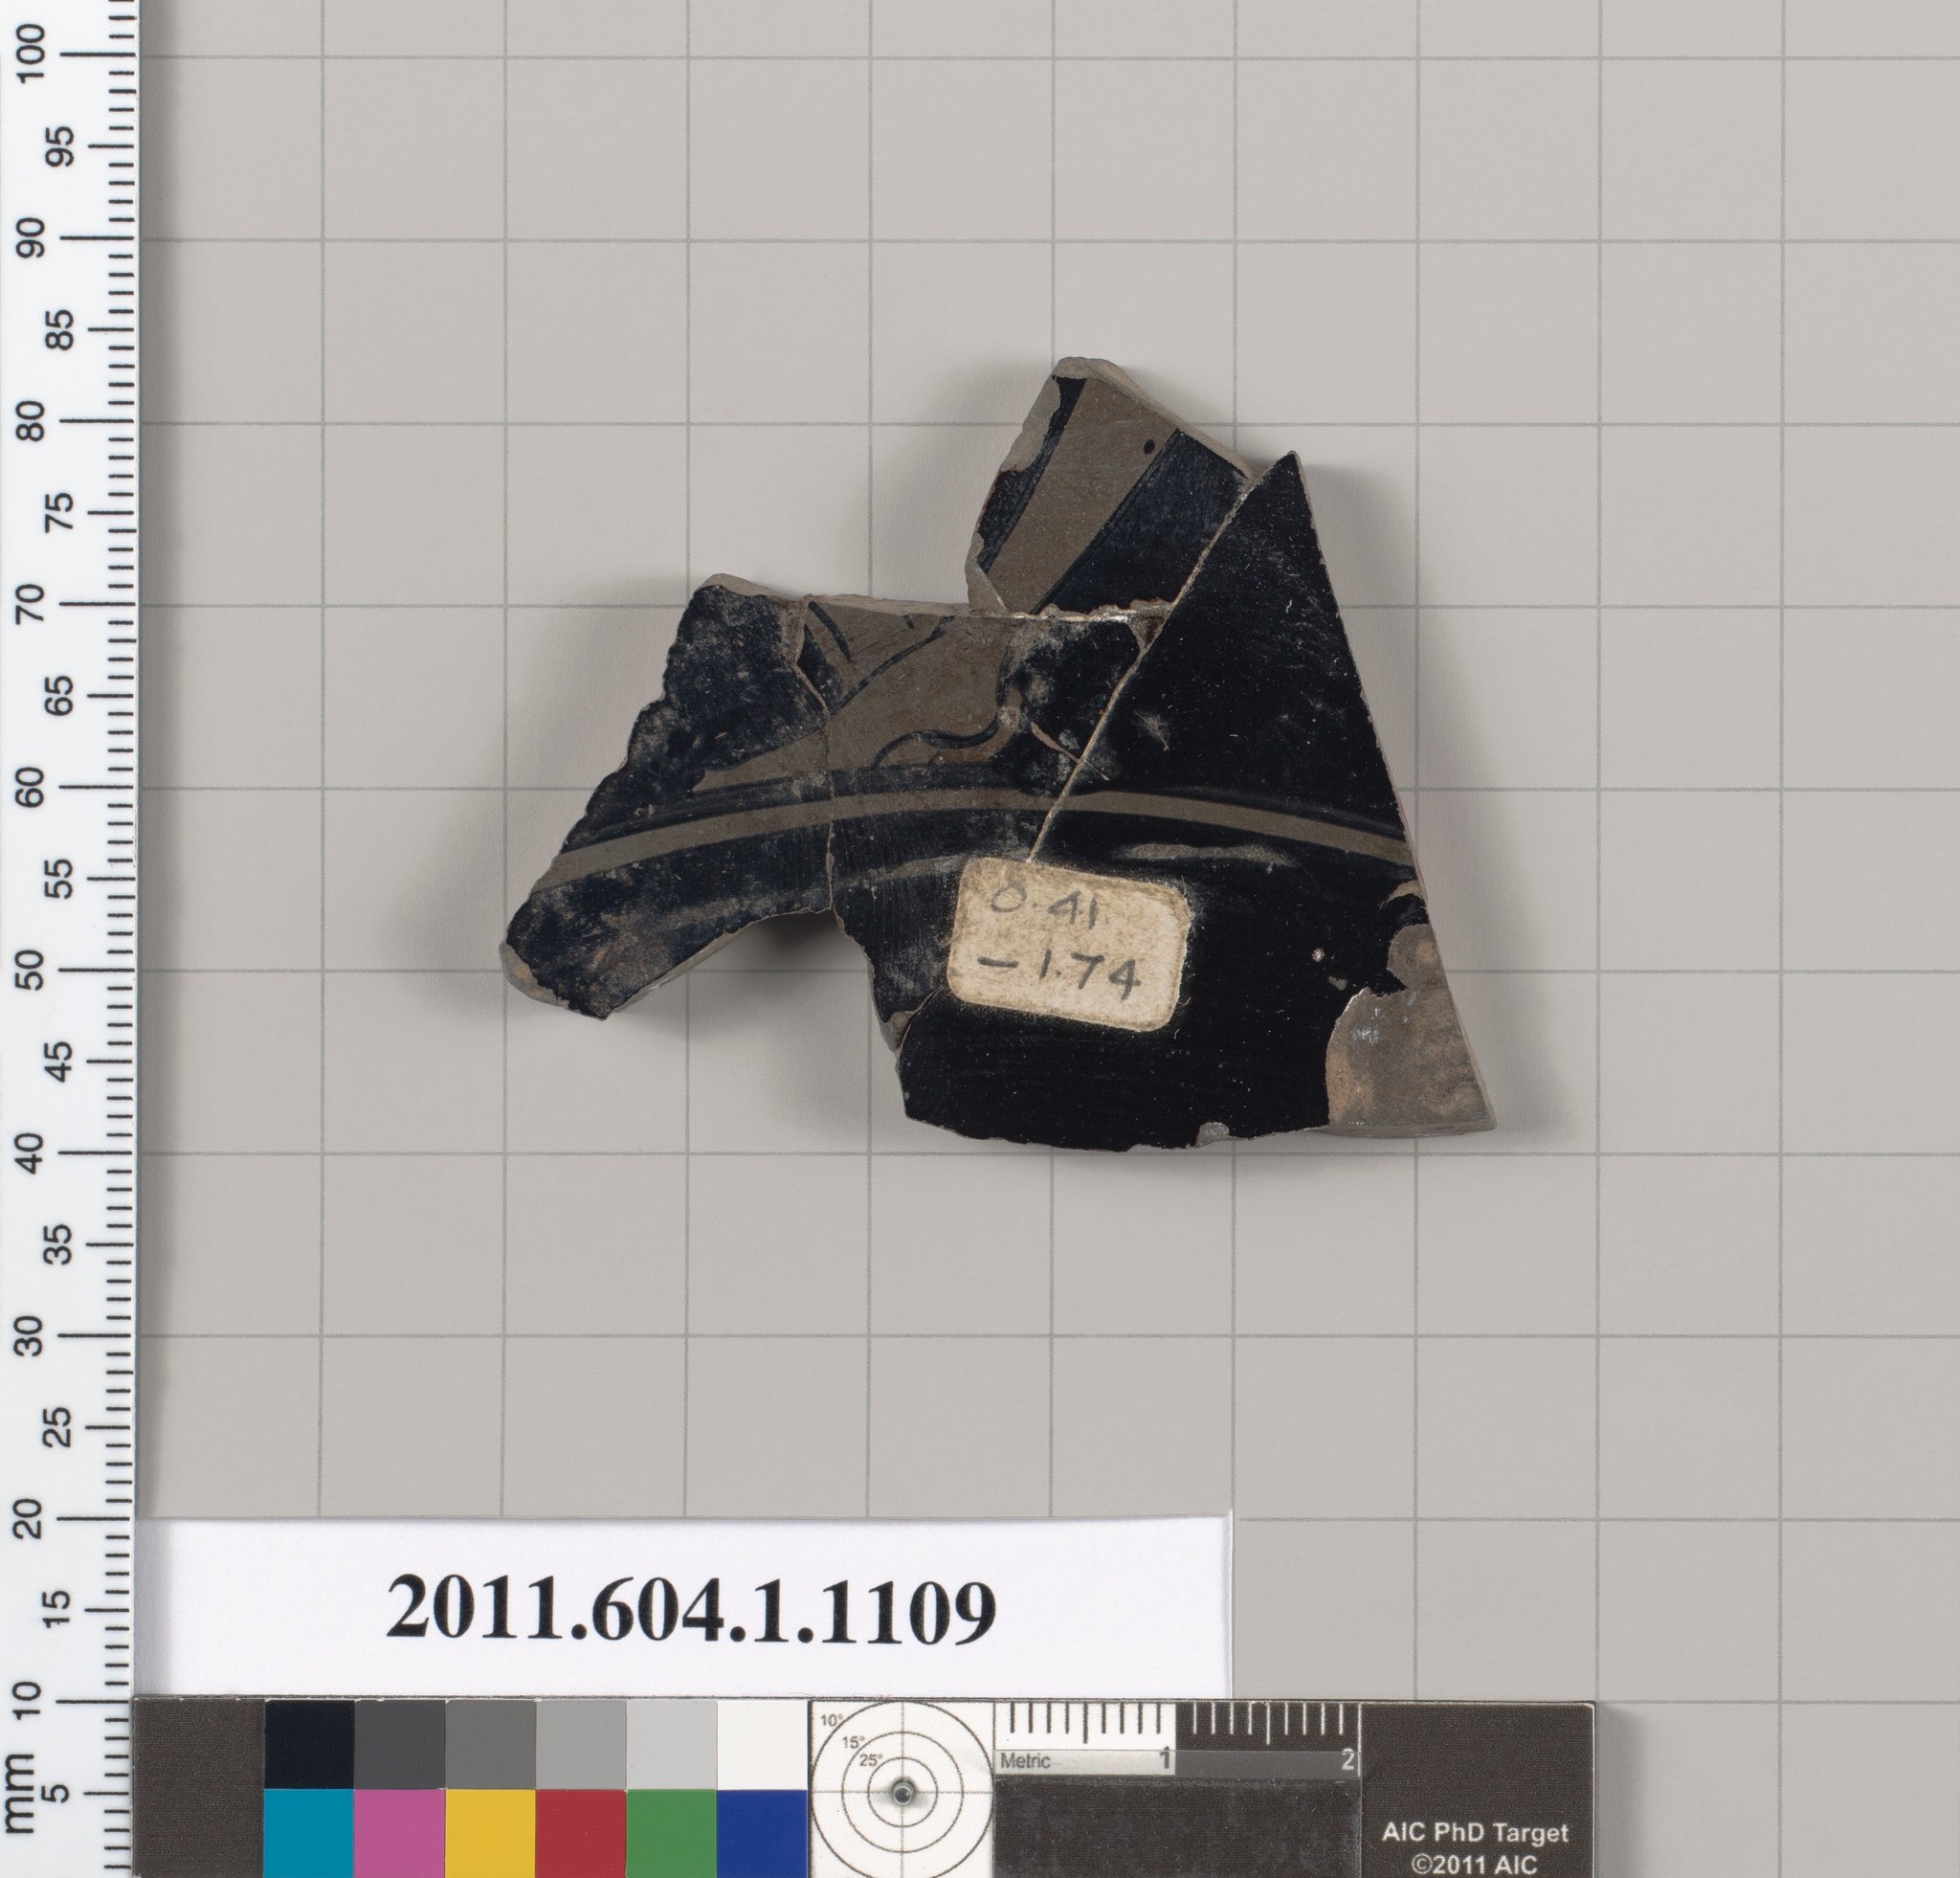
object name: kylix fragment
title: Terracotta fragment of a kylix (drinking cup)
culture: greek, attic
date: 500-476 BCE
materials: terracotta